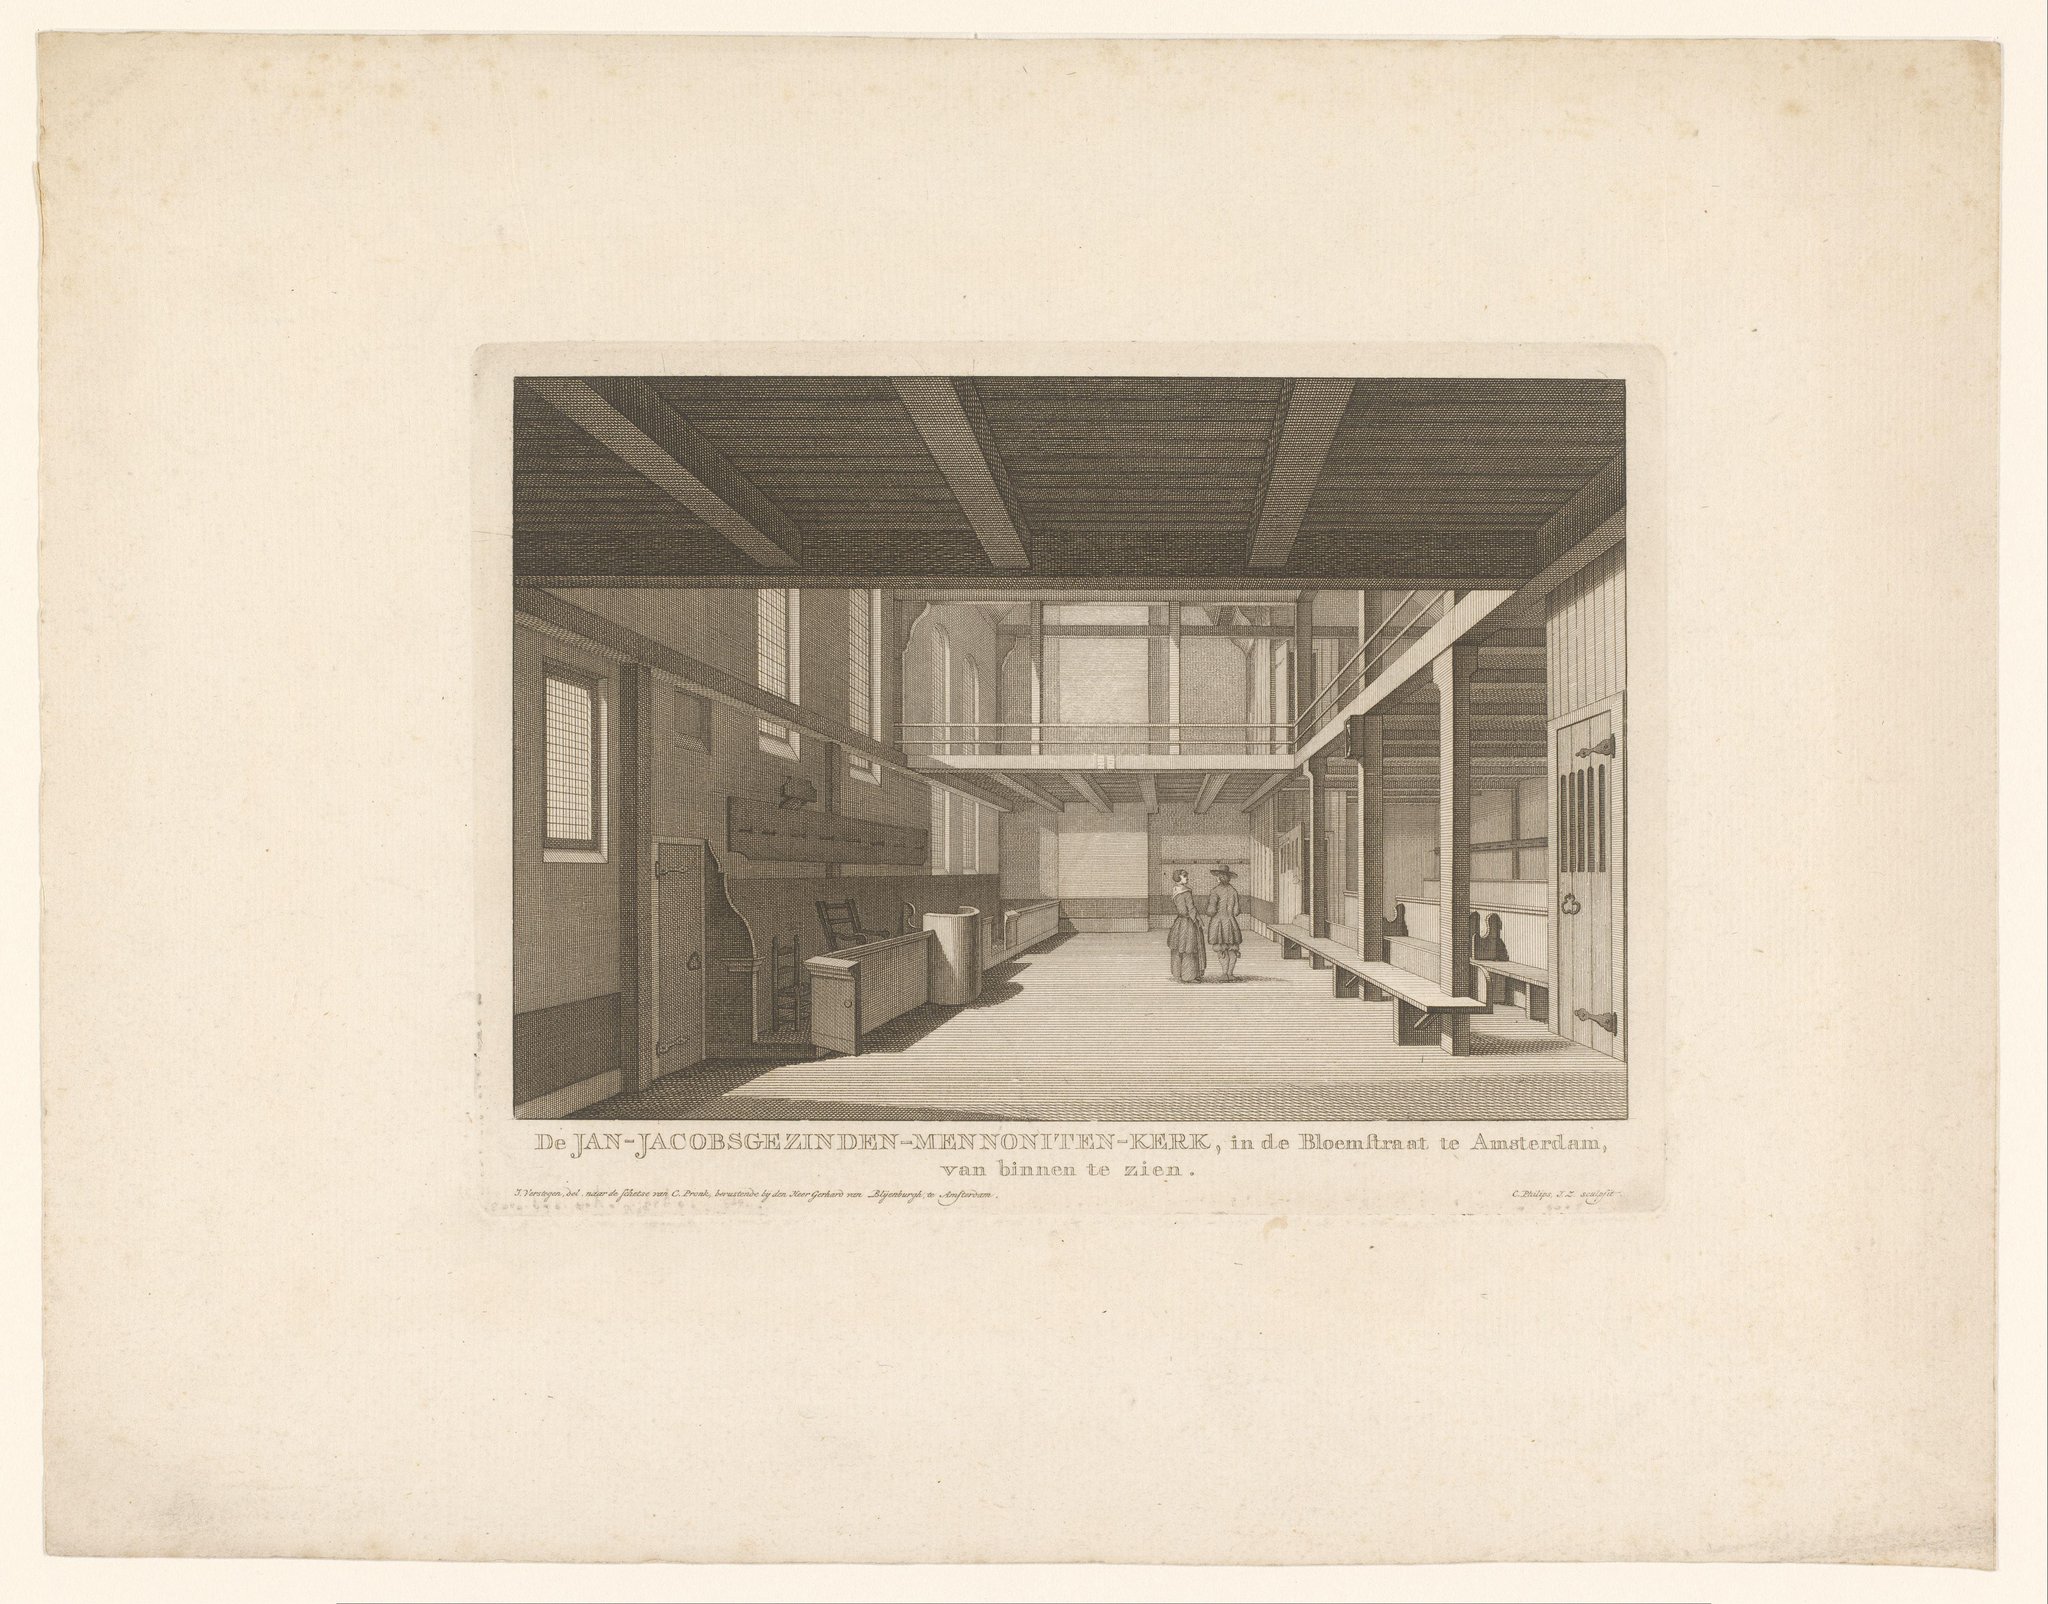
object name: book illustration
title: De Jan-Jacobsgezinden-Mennoniten-kerk, in de Bloemstraat te Amsterdam, van binnen te zien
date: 1760-1767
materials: paper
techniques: etching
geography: amsterdam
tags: interior of church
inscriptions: collector's mark: Lugt 2228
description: Prent waarschijnlijk uit een deel van: Wagenaar, Jan. Amsterdam, in zyne opkomst, aanwas, geschiedenissen (...). Amsterdam: Isaak Tirion en Yntema & Tieboel, 1760-1767.